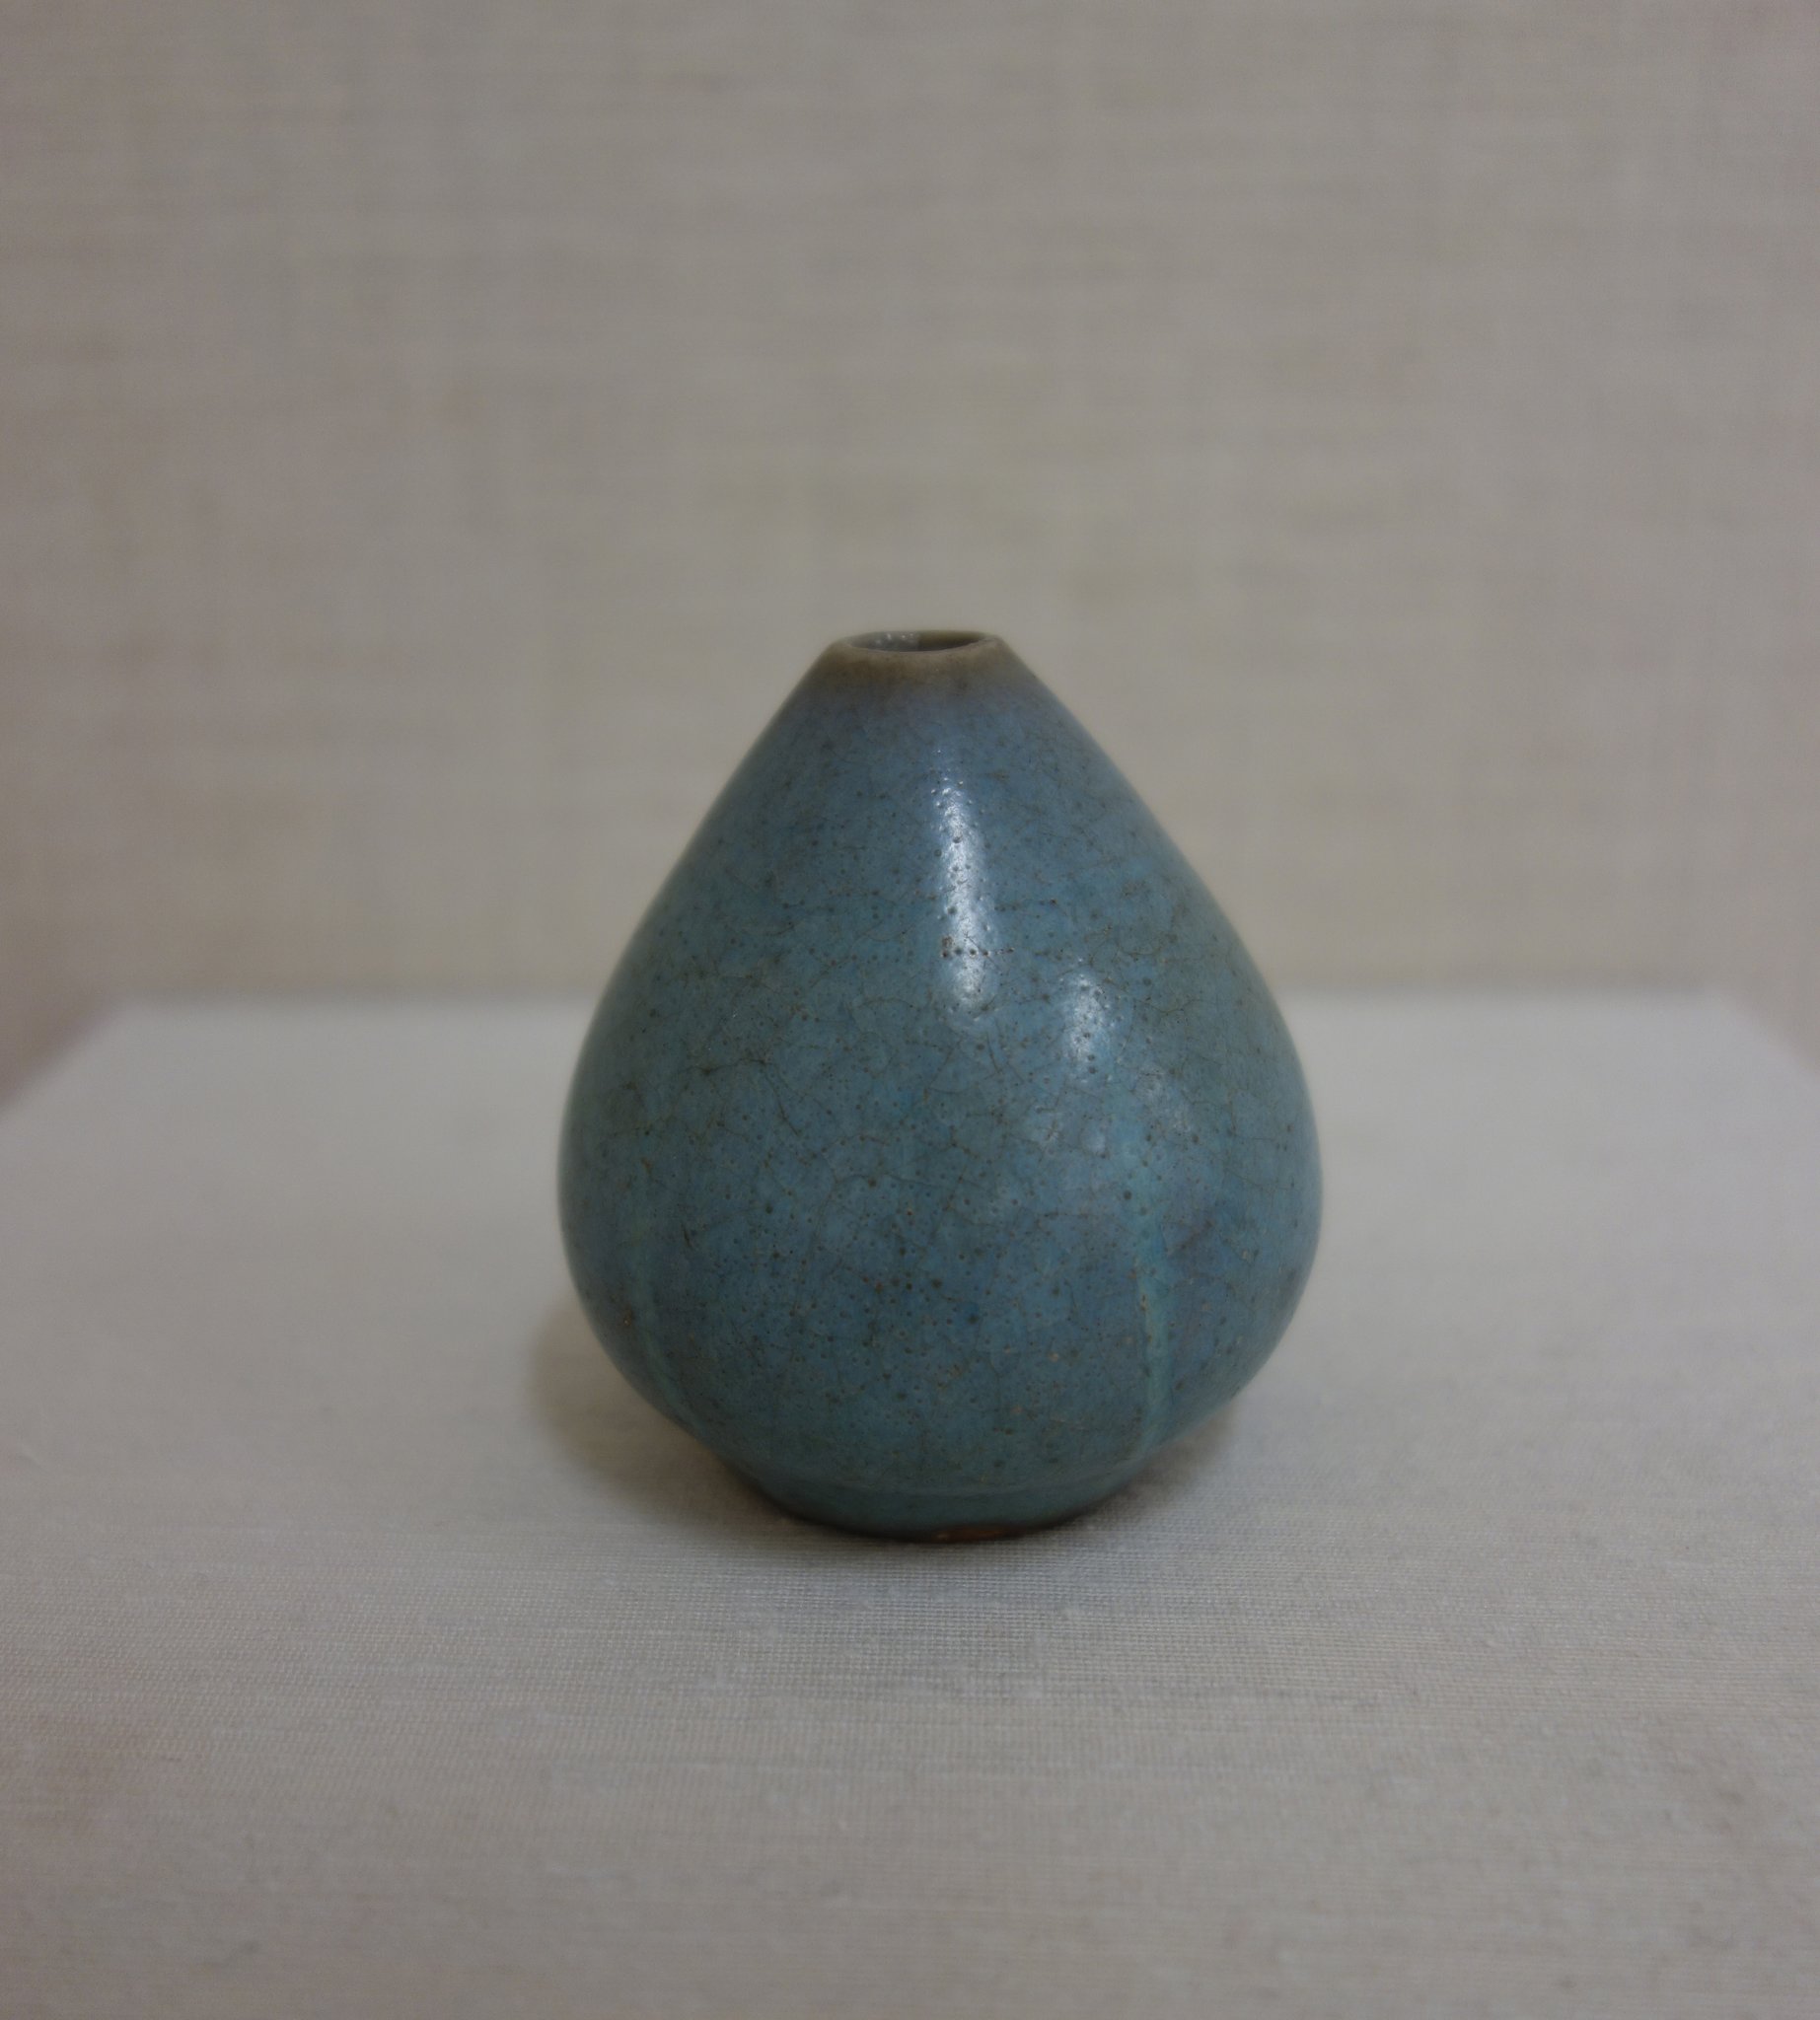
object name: water dropper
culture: chinese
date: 1271-1368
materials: glaze, stoneware